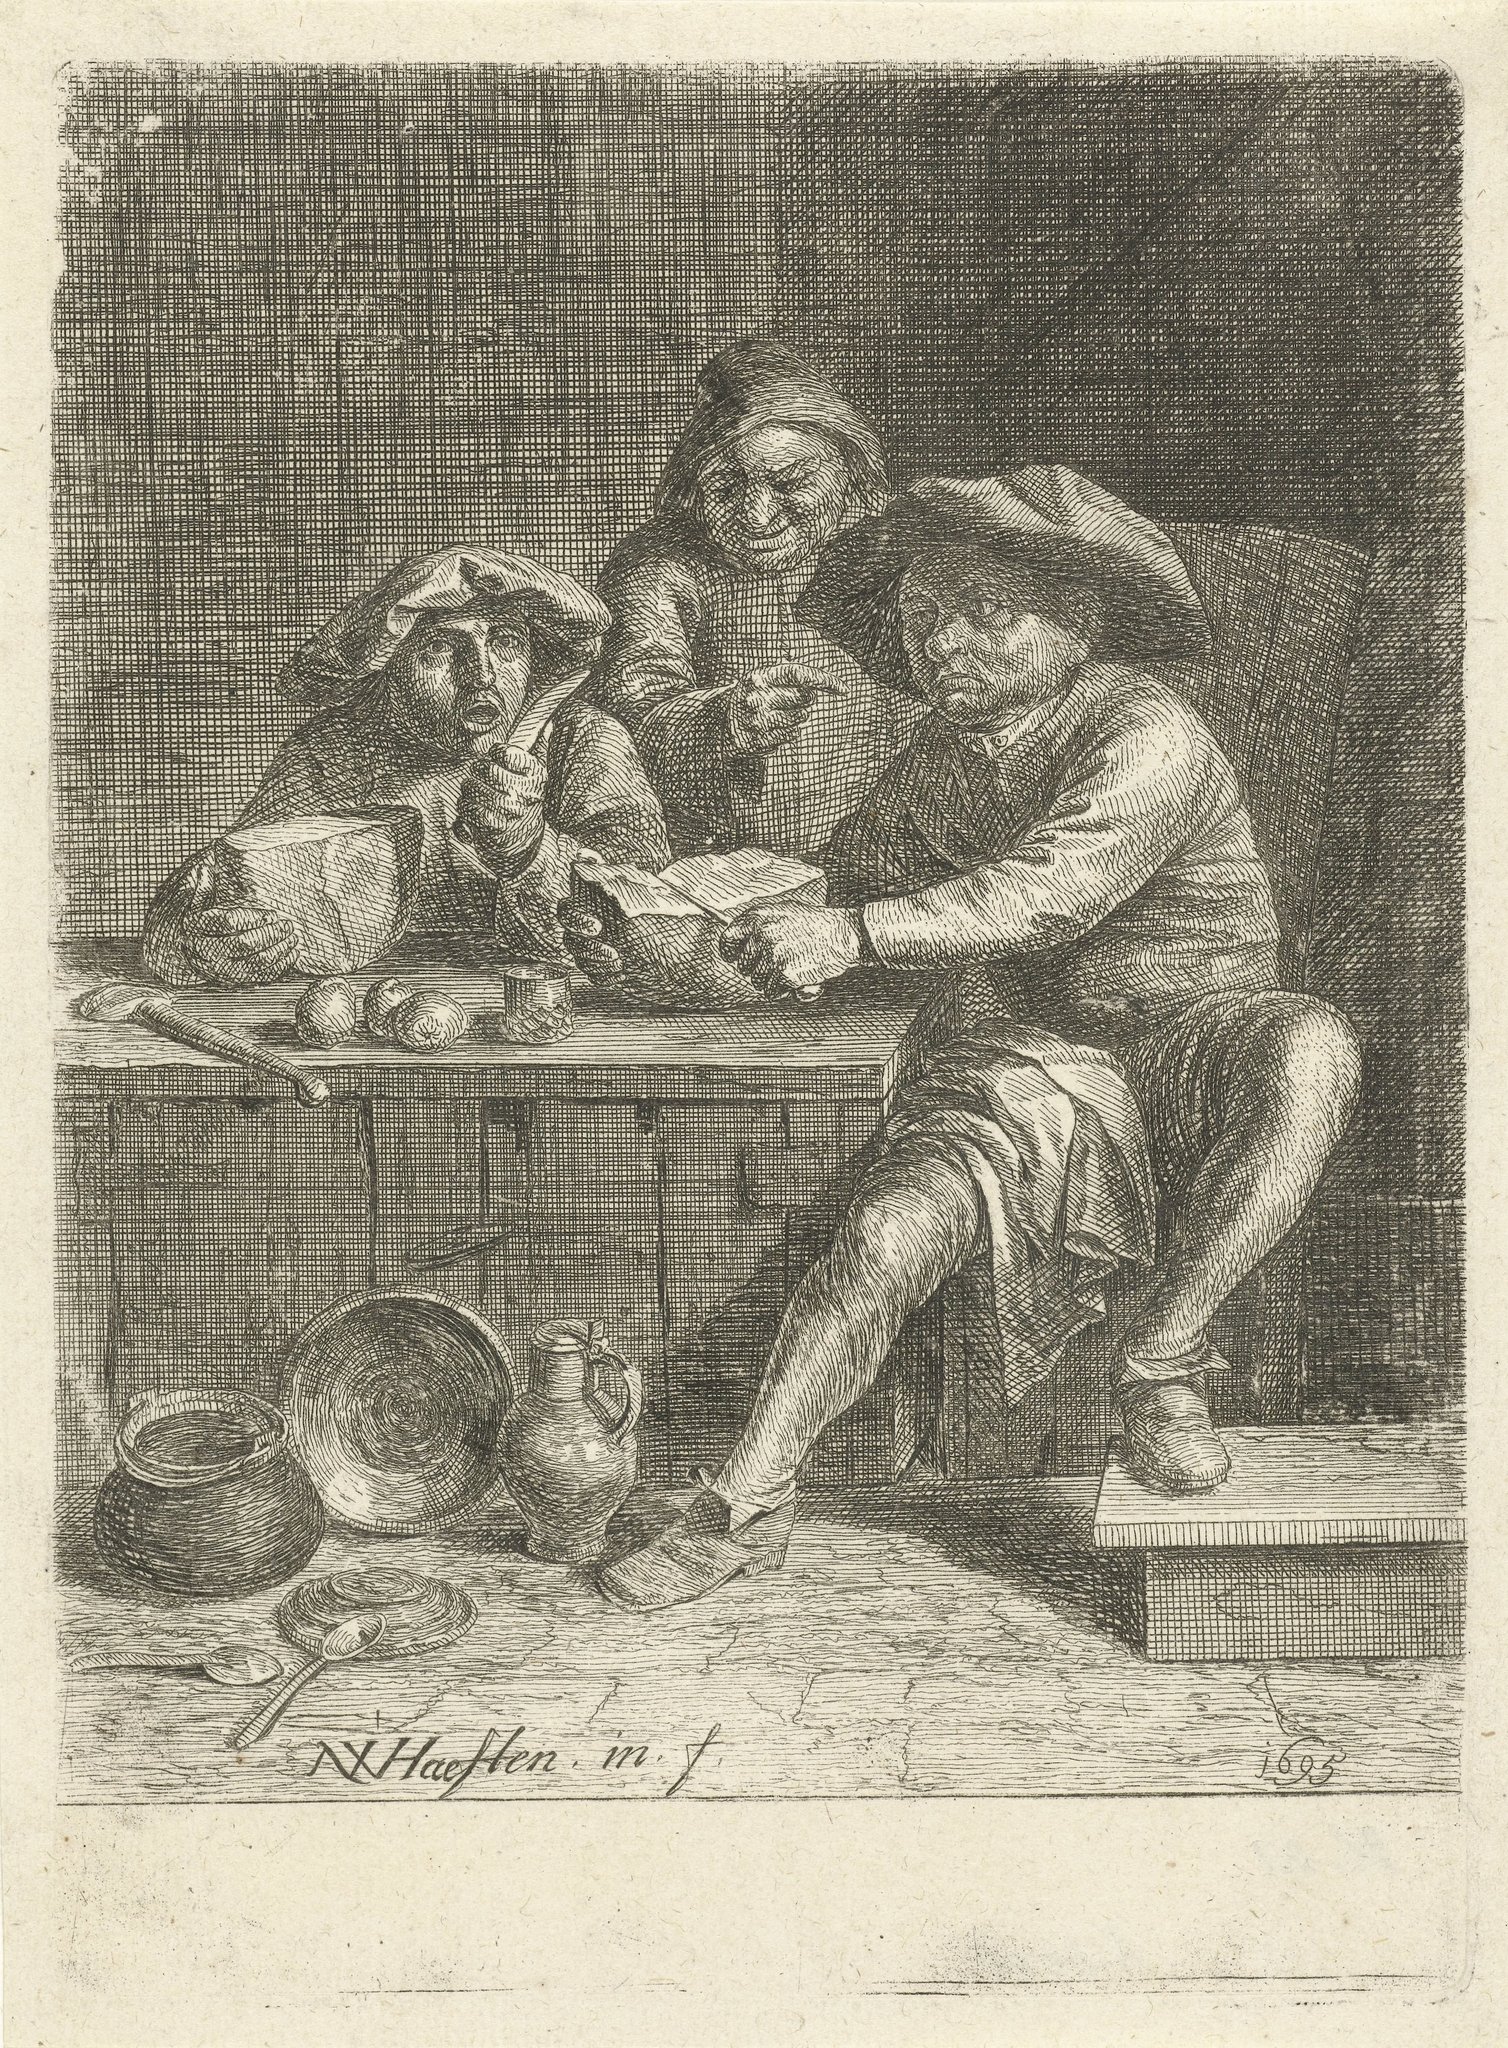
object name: print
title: Boeren aan een tafel met brood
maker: nicolaes van haeften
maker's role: draughtsman, painter, print maker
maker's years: 1653-1715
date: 1695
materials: paper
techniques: etching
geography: paris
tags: farmers, eating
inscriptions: collector's mark: Lugt 2228